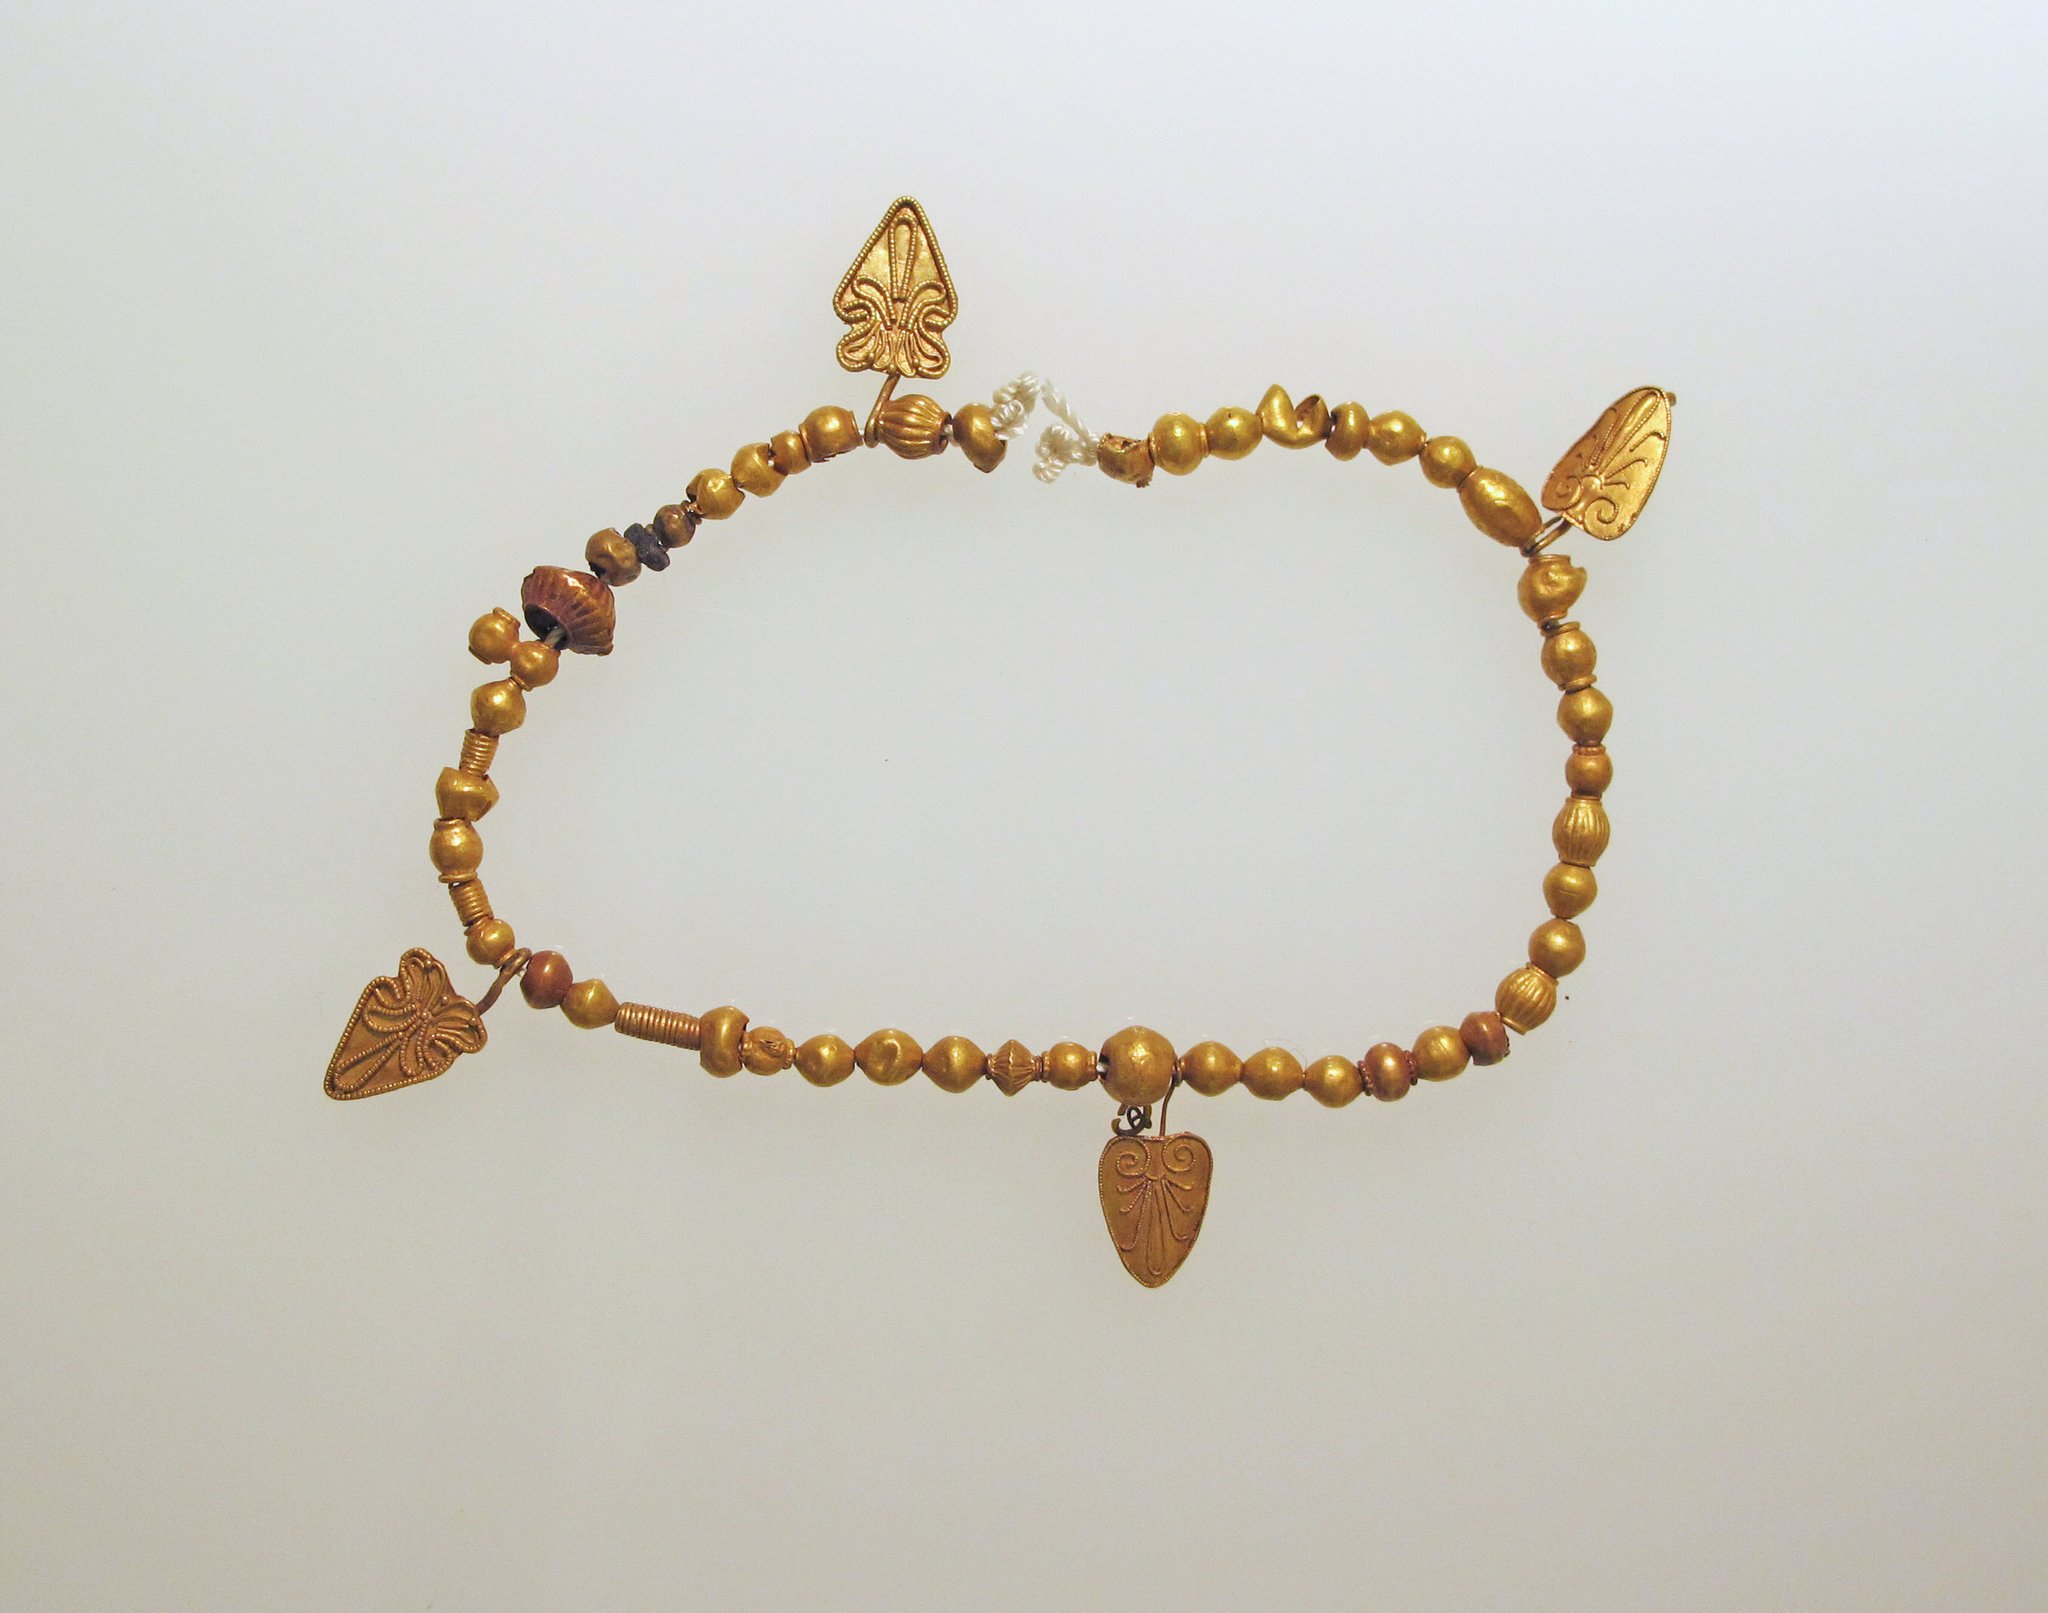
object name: necklace with palmette pendant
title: Necklace with palmette pendants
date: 7000 BCE-330 CE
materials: gold